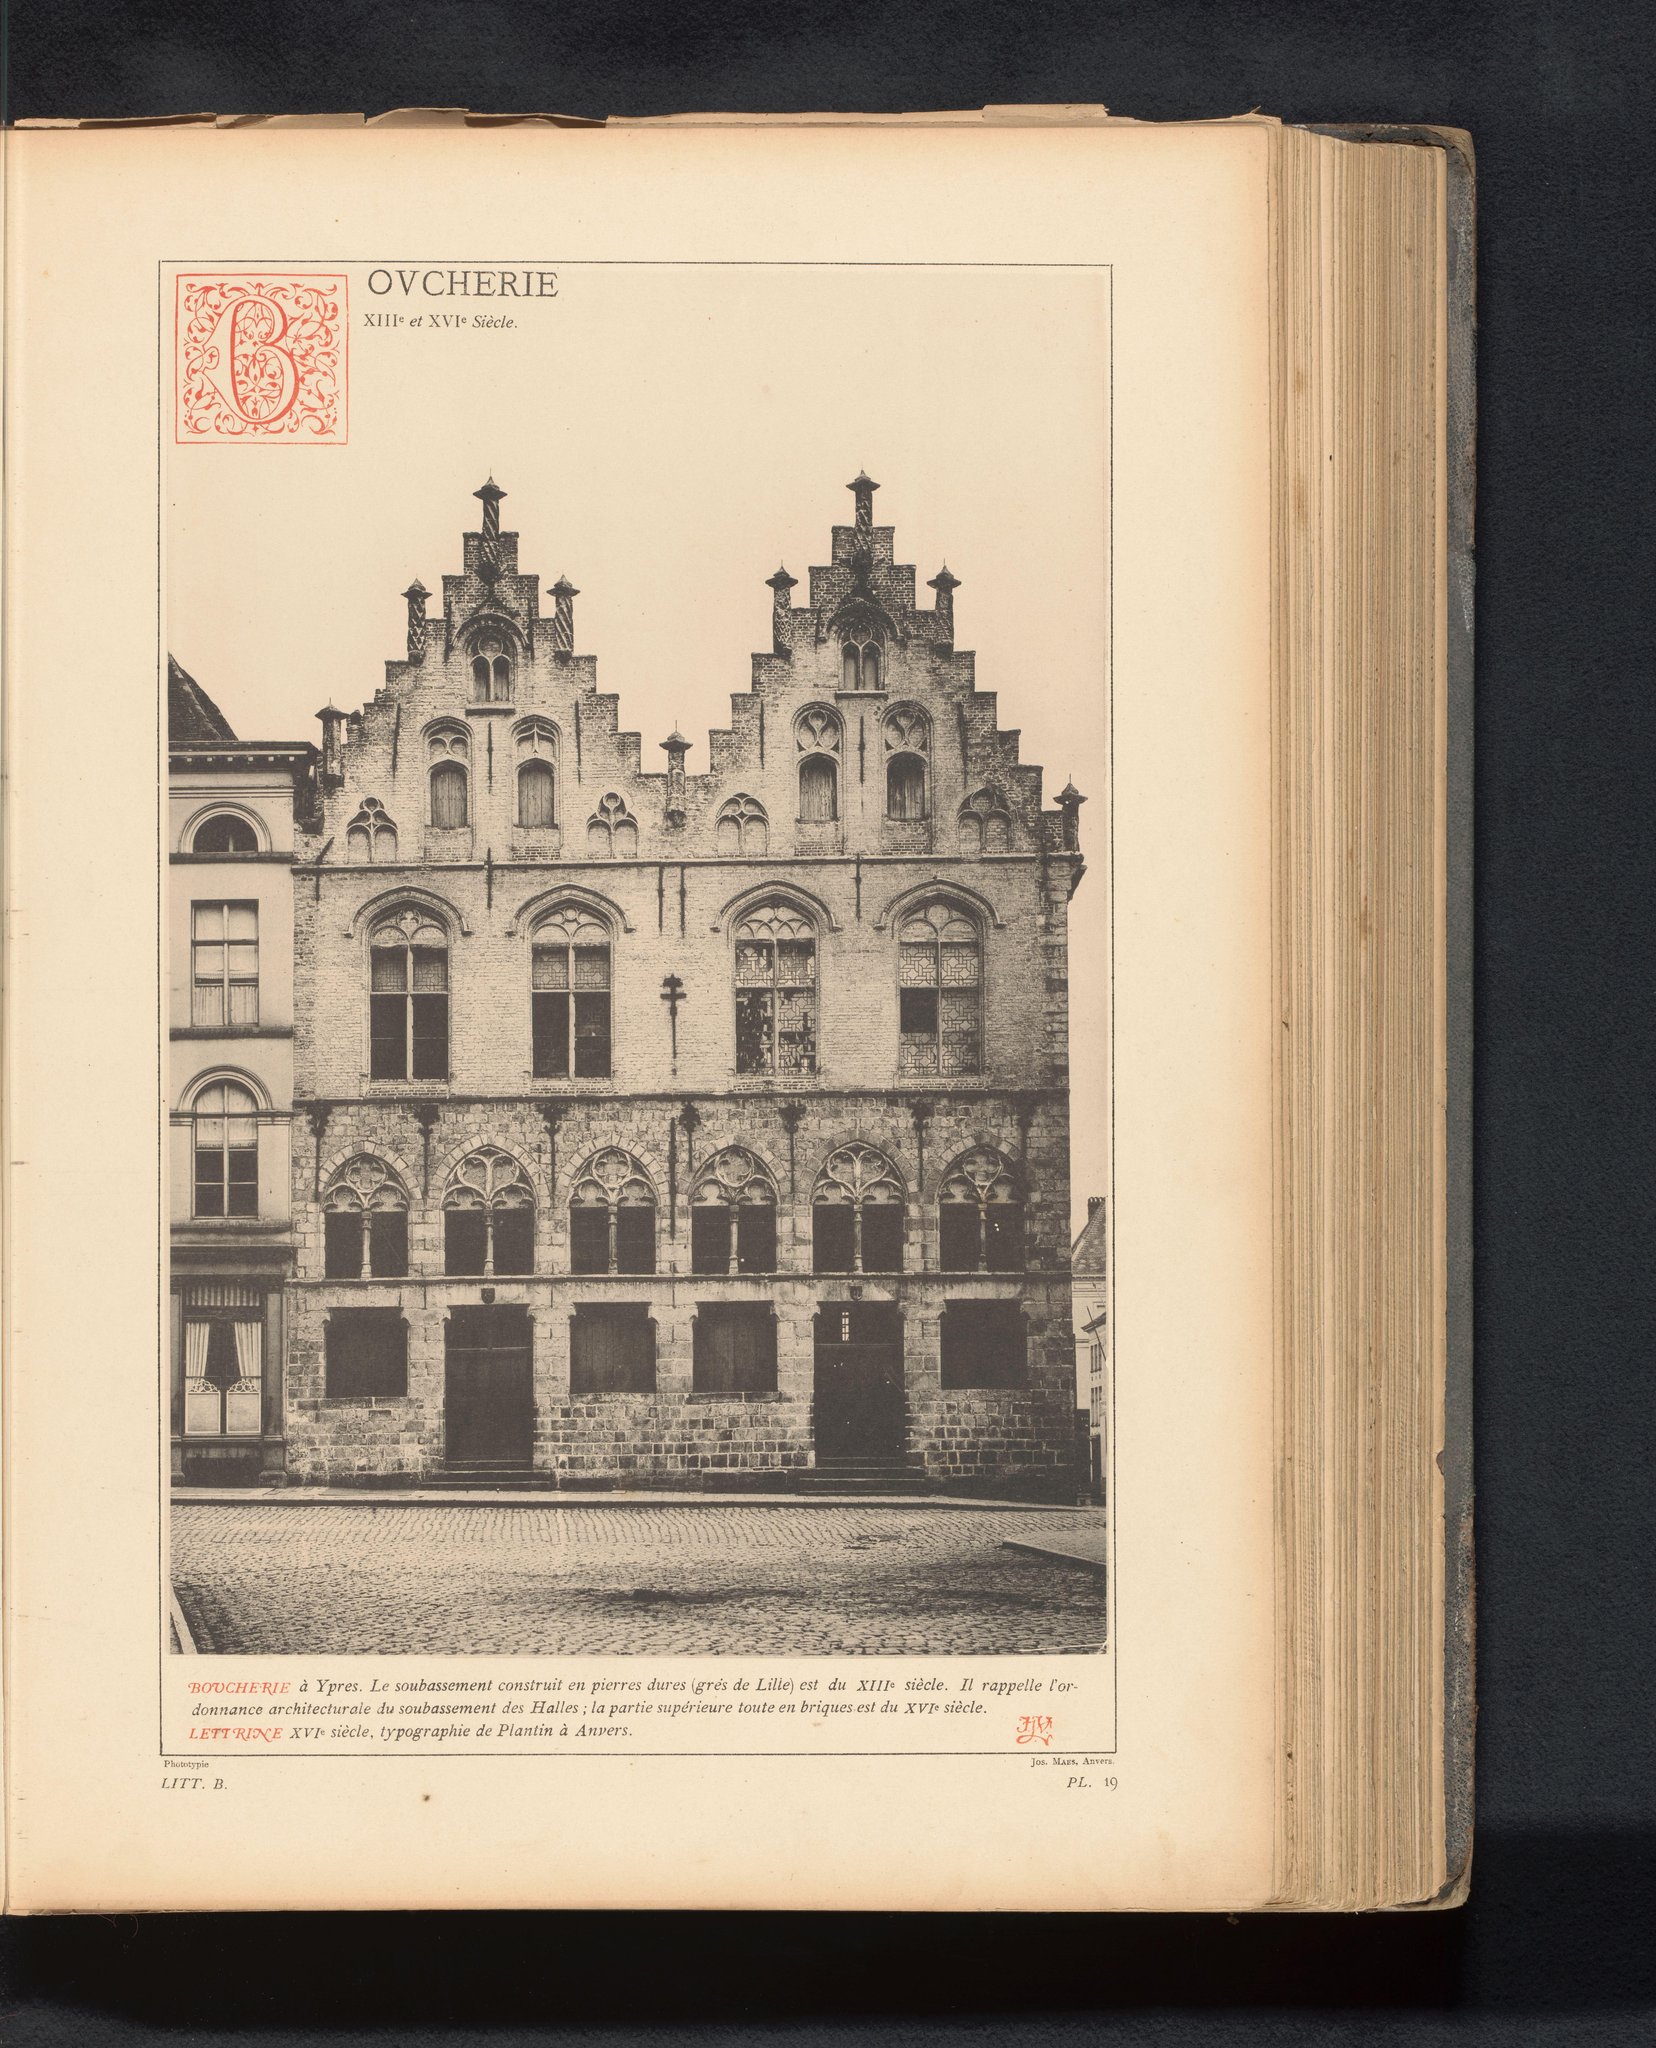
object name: page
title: Boucherie, XIIIe et XVIe Siècle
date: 1875-1880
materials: paper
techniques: photograph, photolithography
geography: ieper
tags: butcher, slaughterman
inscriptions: monogram: ‘JJvY’, inscription: ‘LITT. B. - PL. 19’, inscription: ‘Boucherie à Ypres (...)’